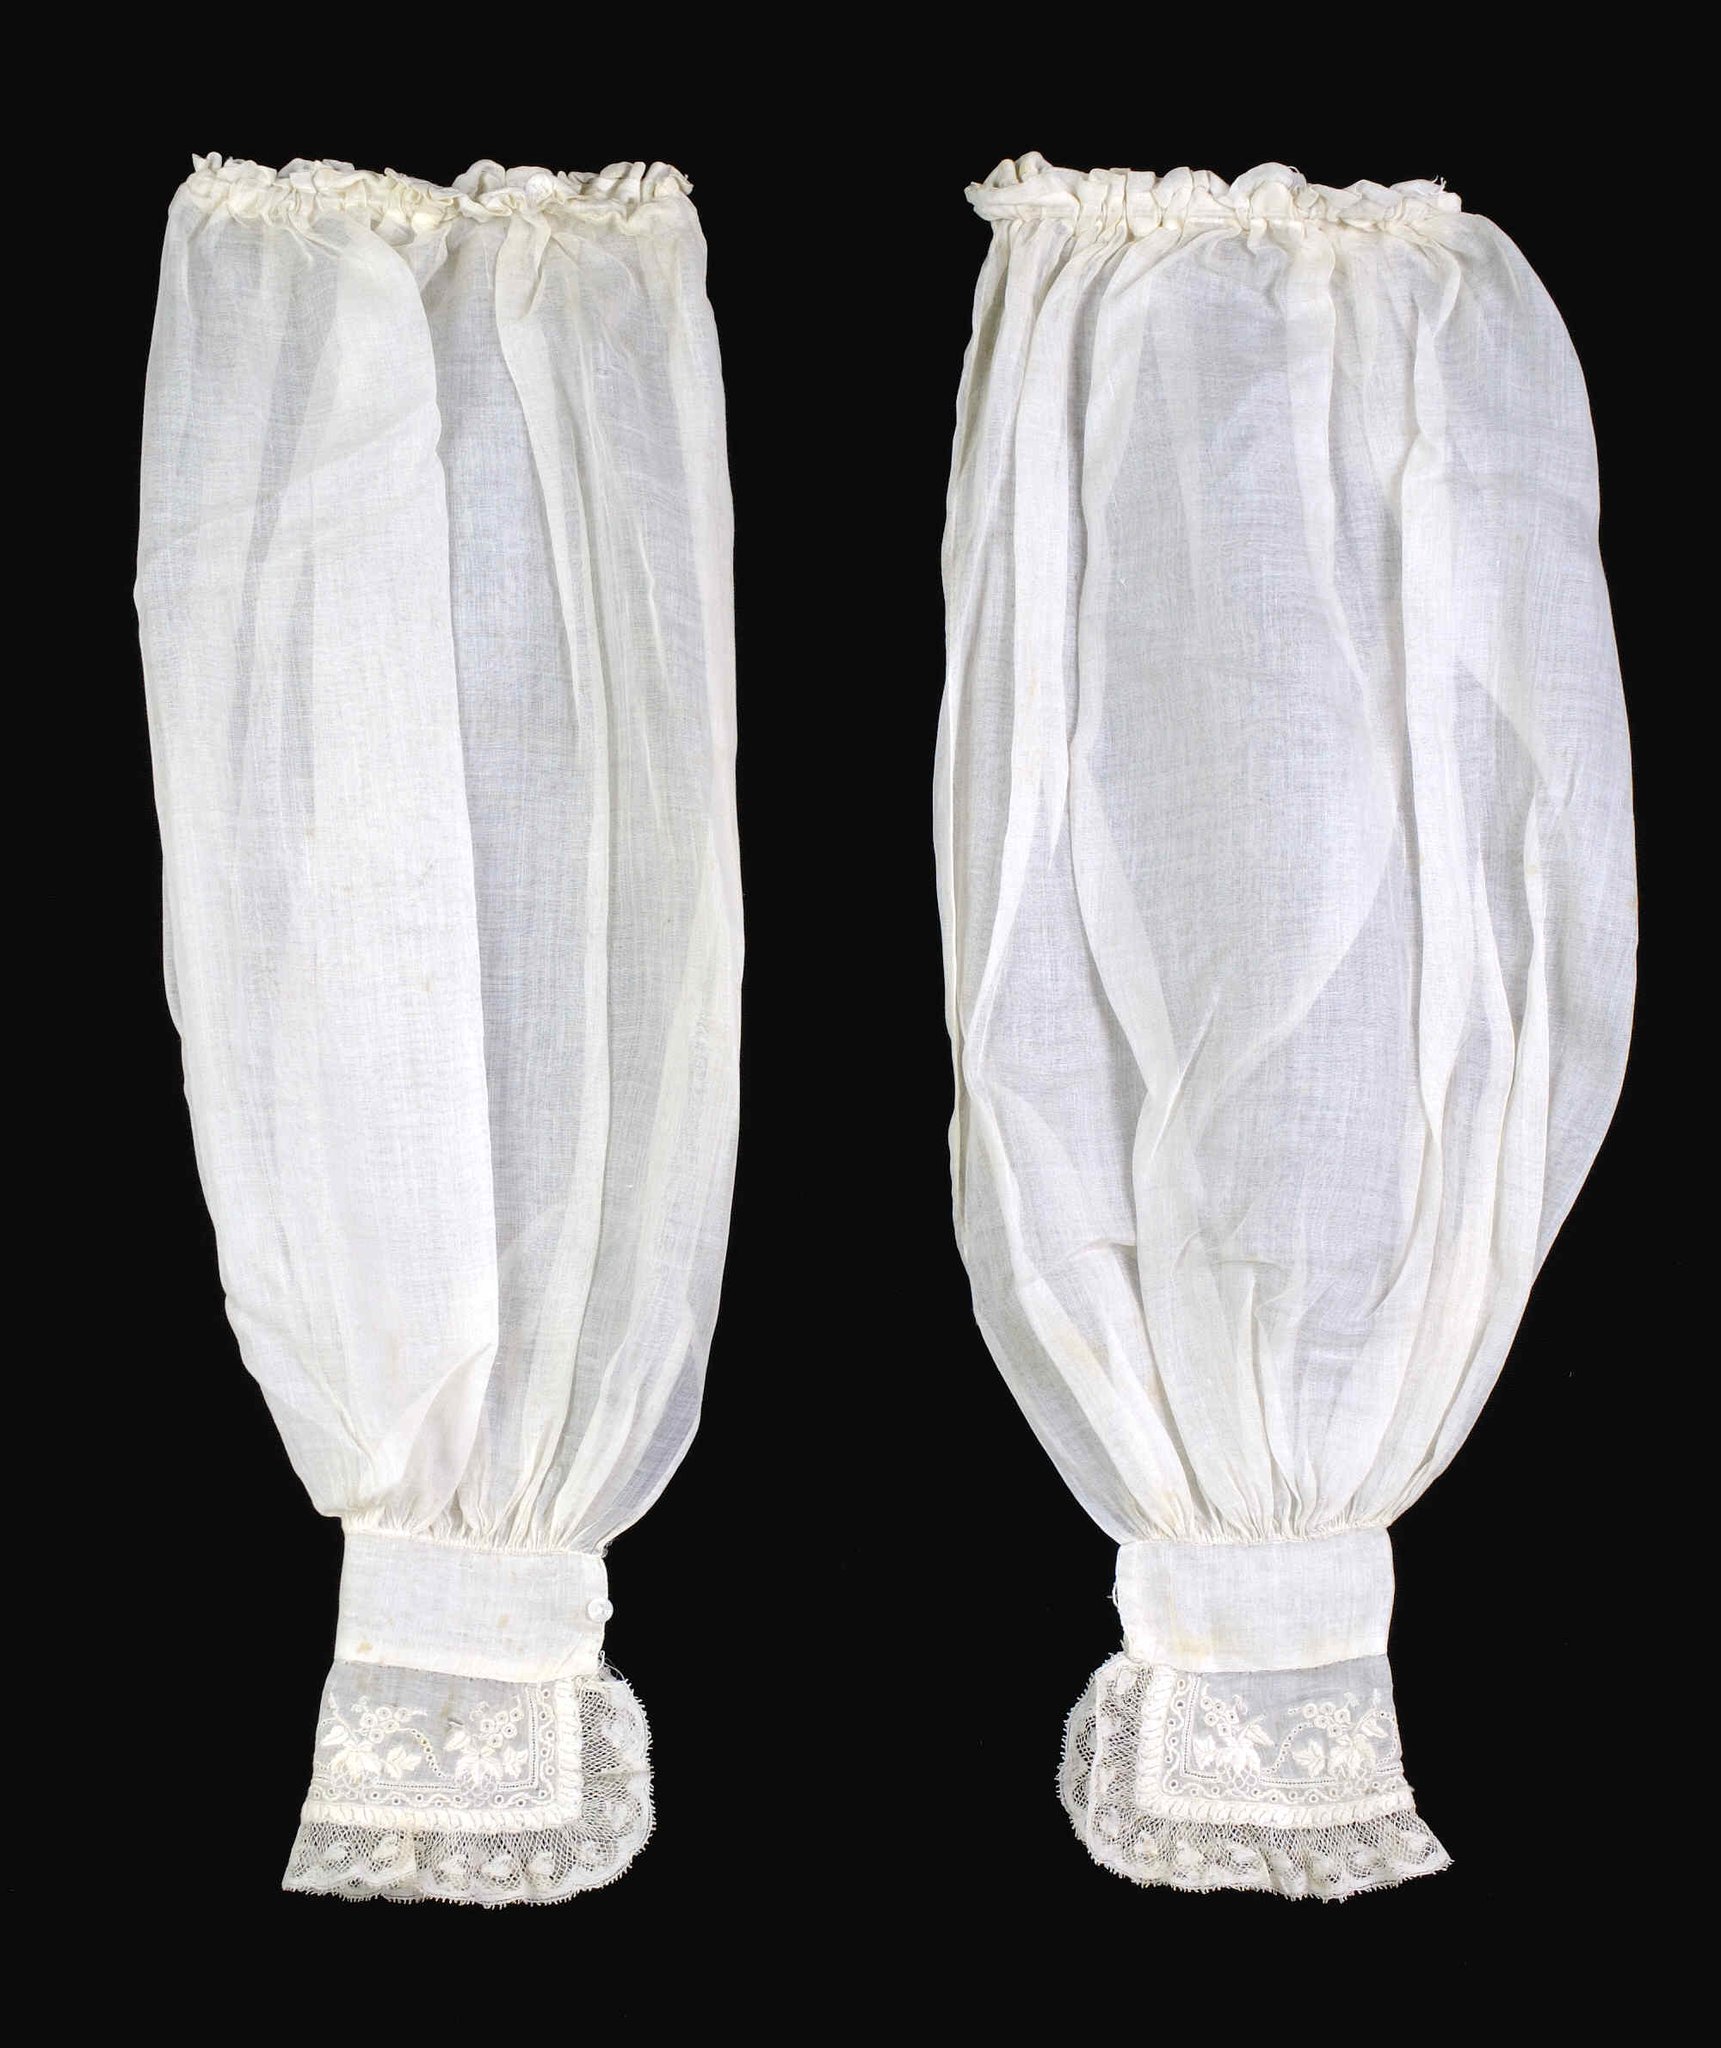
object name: undersleeves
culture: american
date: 1850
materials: cotton